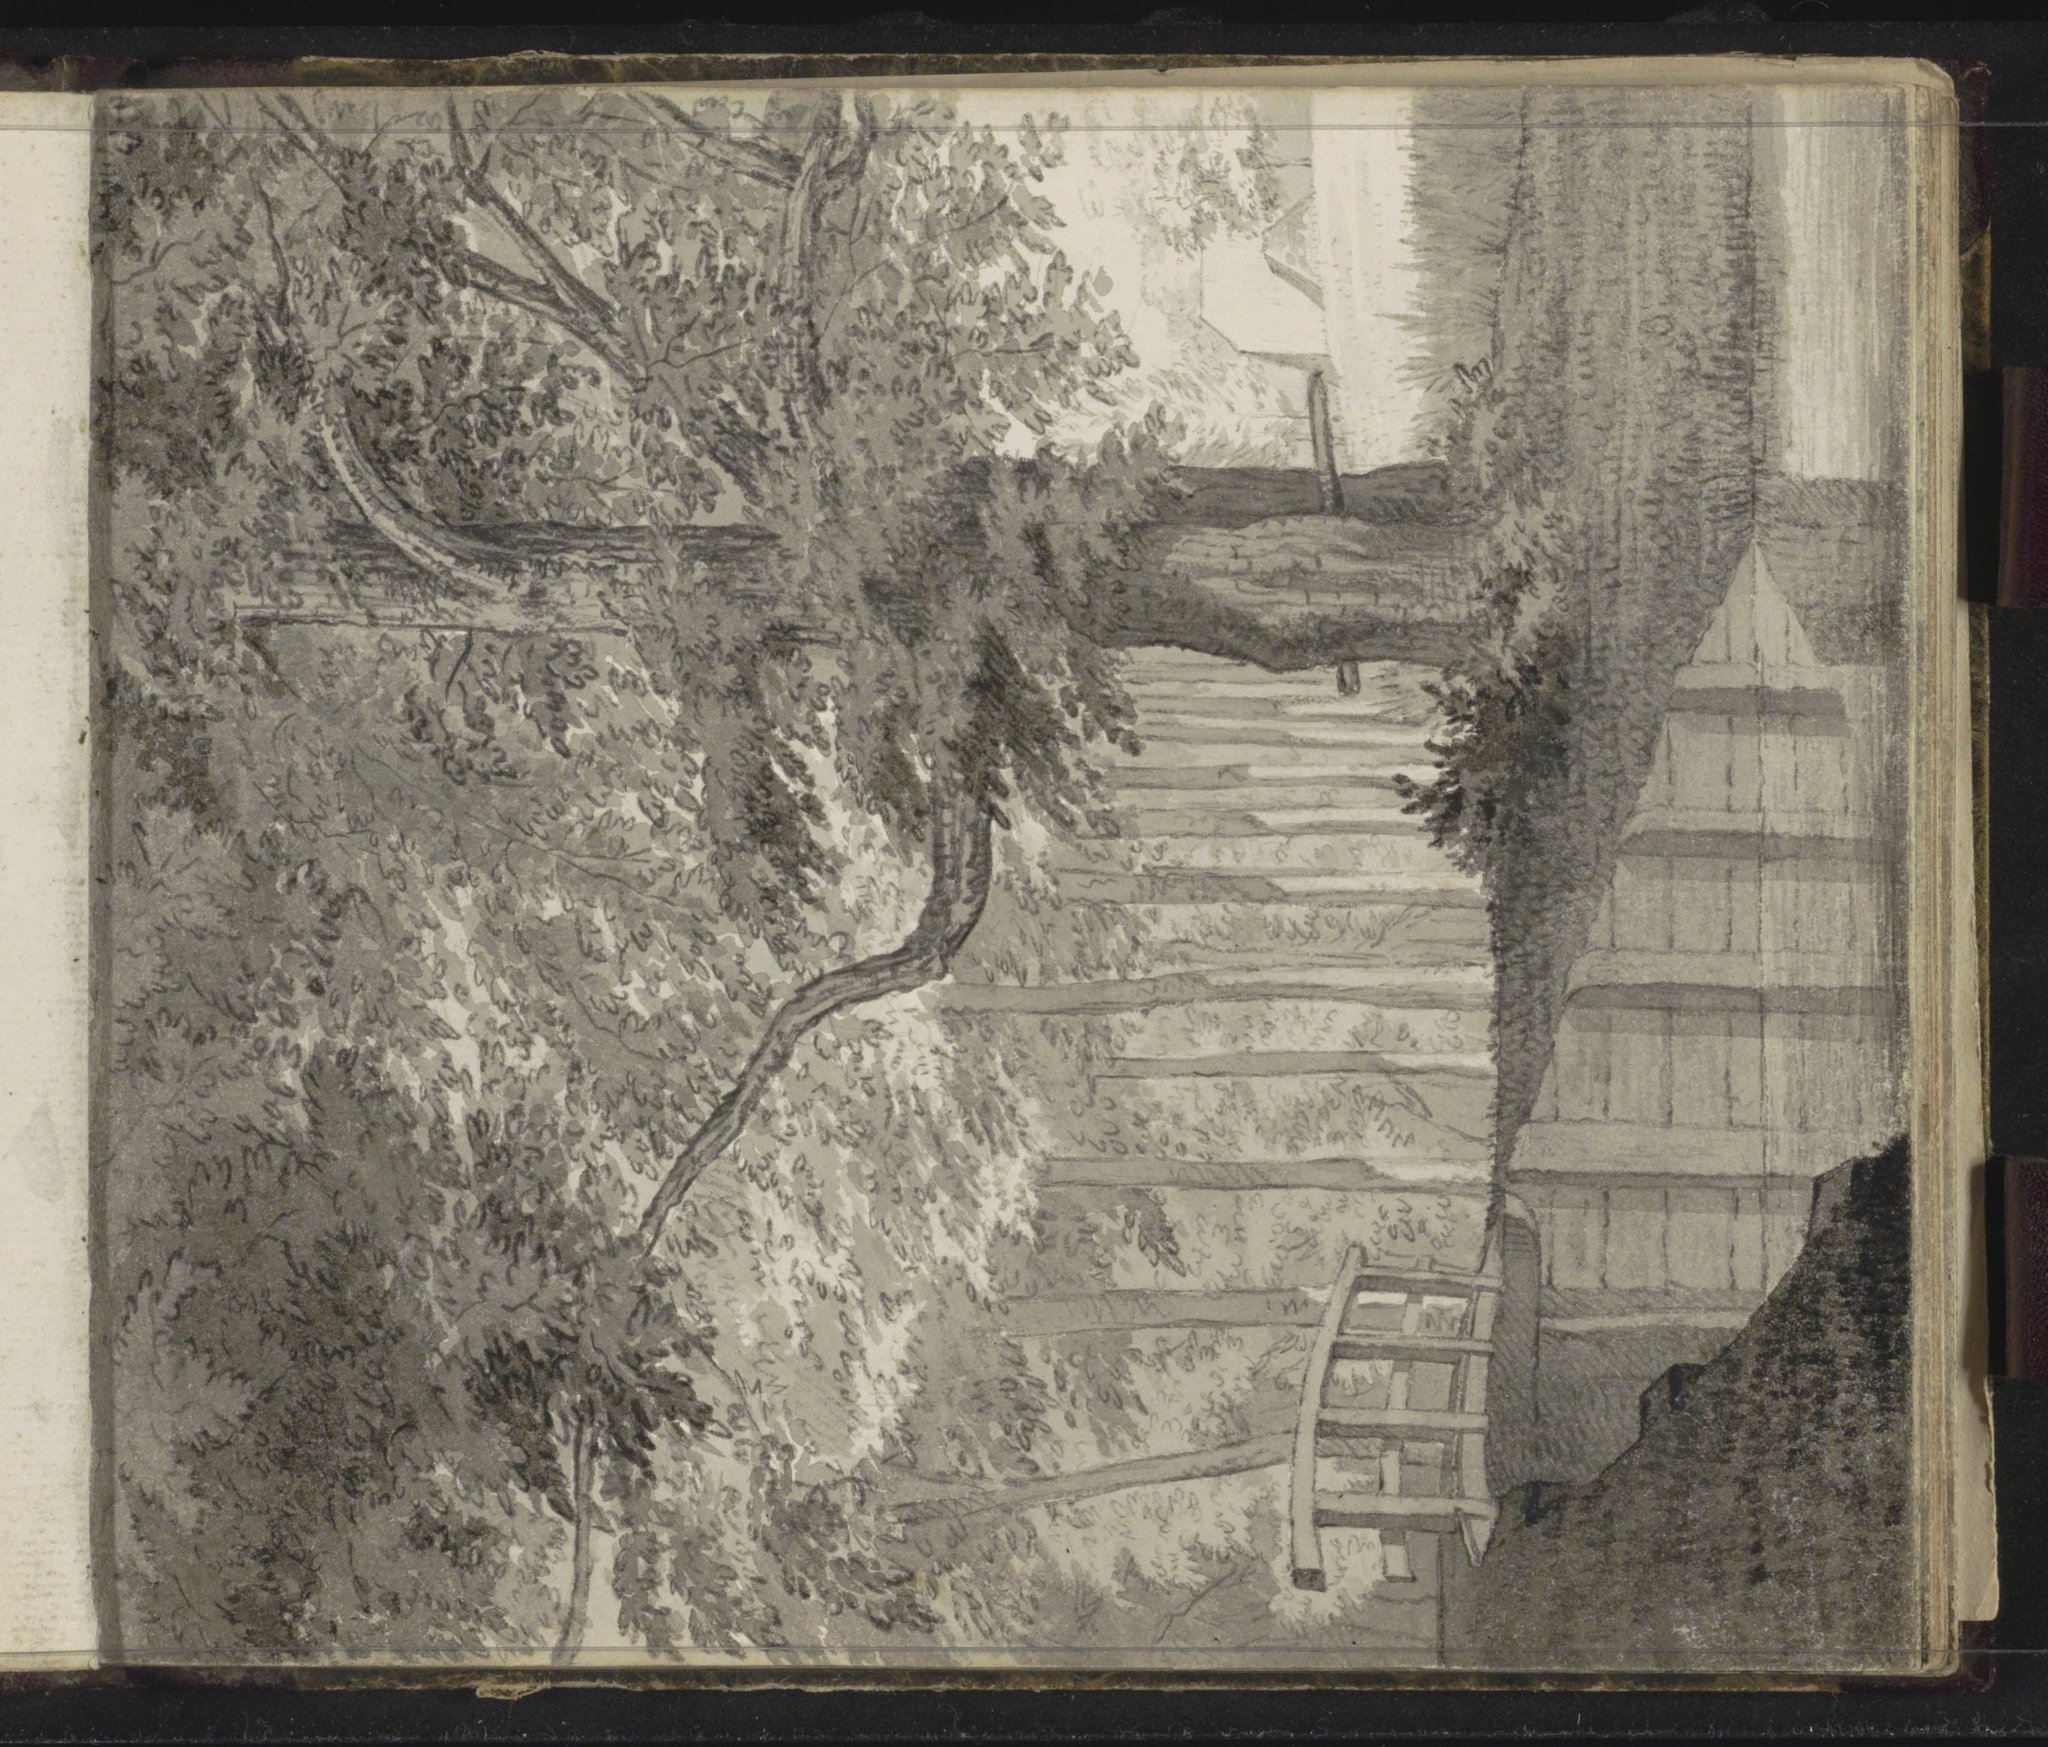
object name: sketchbook leaf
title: Boomrijk landschap met een brug over water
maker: hendrik abraham klinkhamer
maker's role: draughtsman, painter, print maker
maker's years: 1810-1872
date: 1820-1872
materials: chalk, paper, watercolor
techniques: brush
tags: landscapes with waters, waterscapes, seascapes (in the temperate zone), bridge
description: Blad 7 recto uit een schetsboek met 39 bladen.